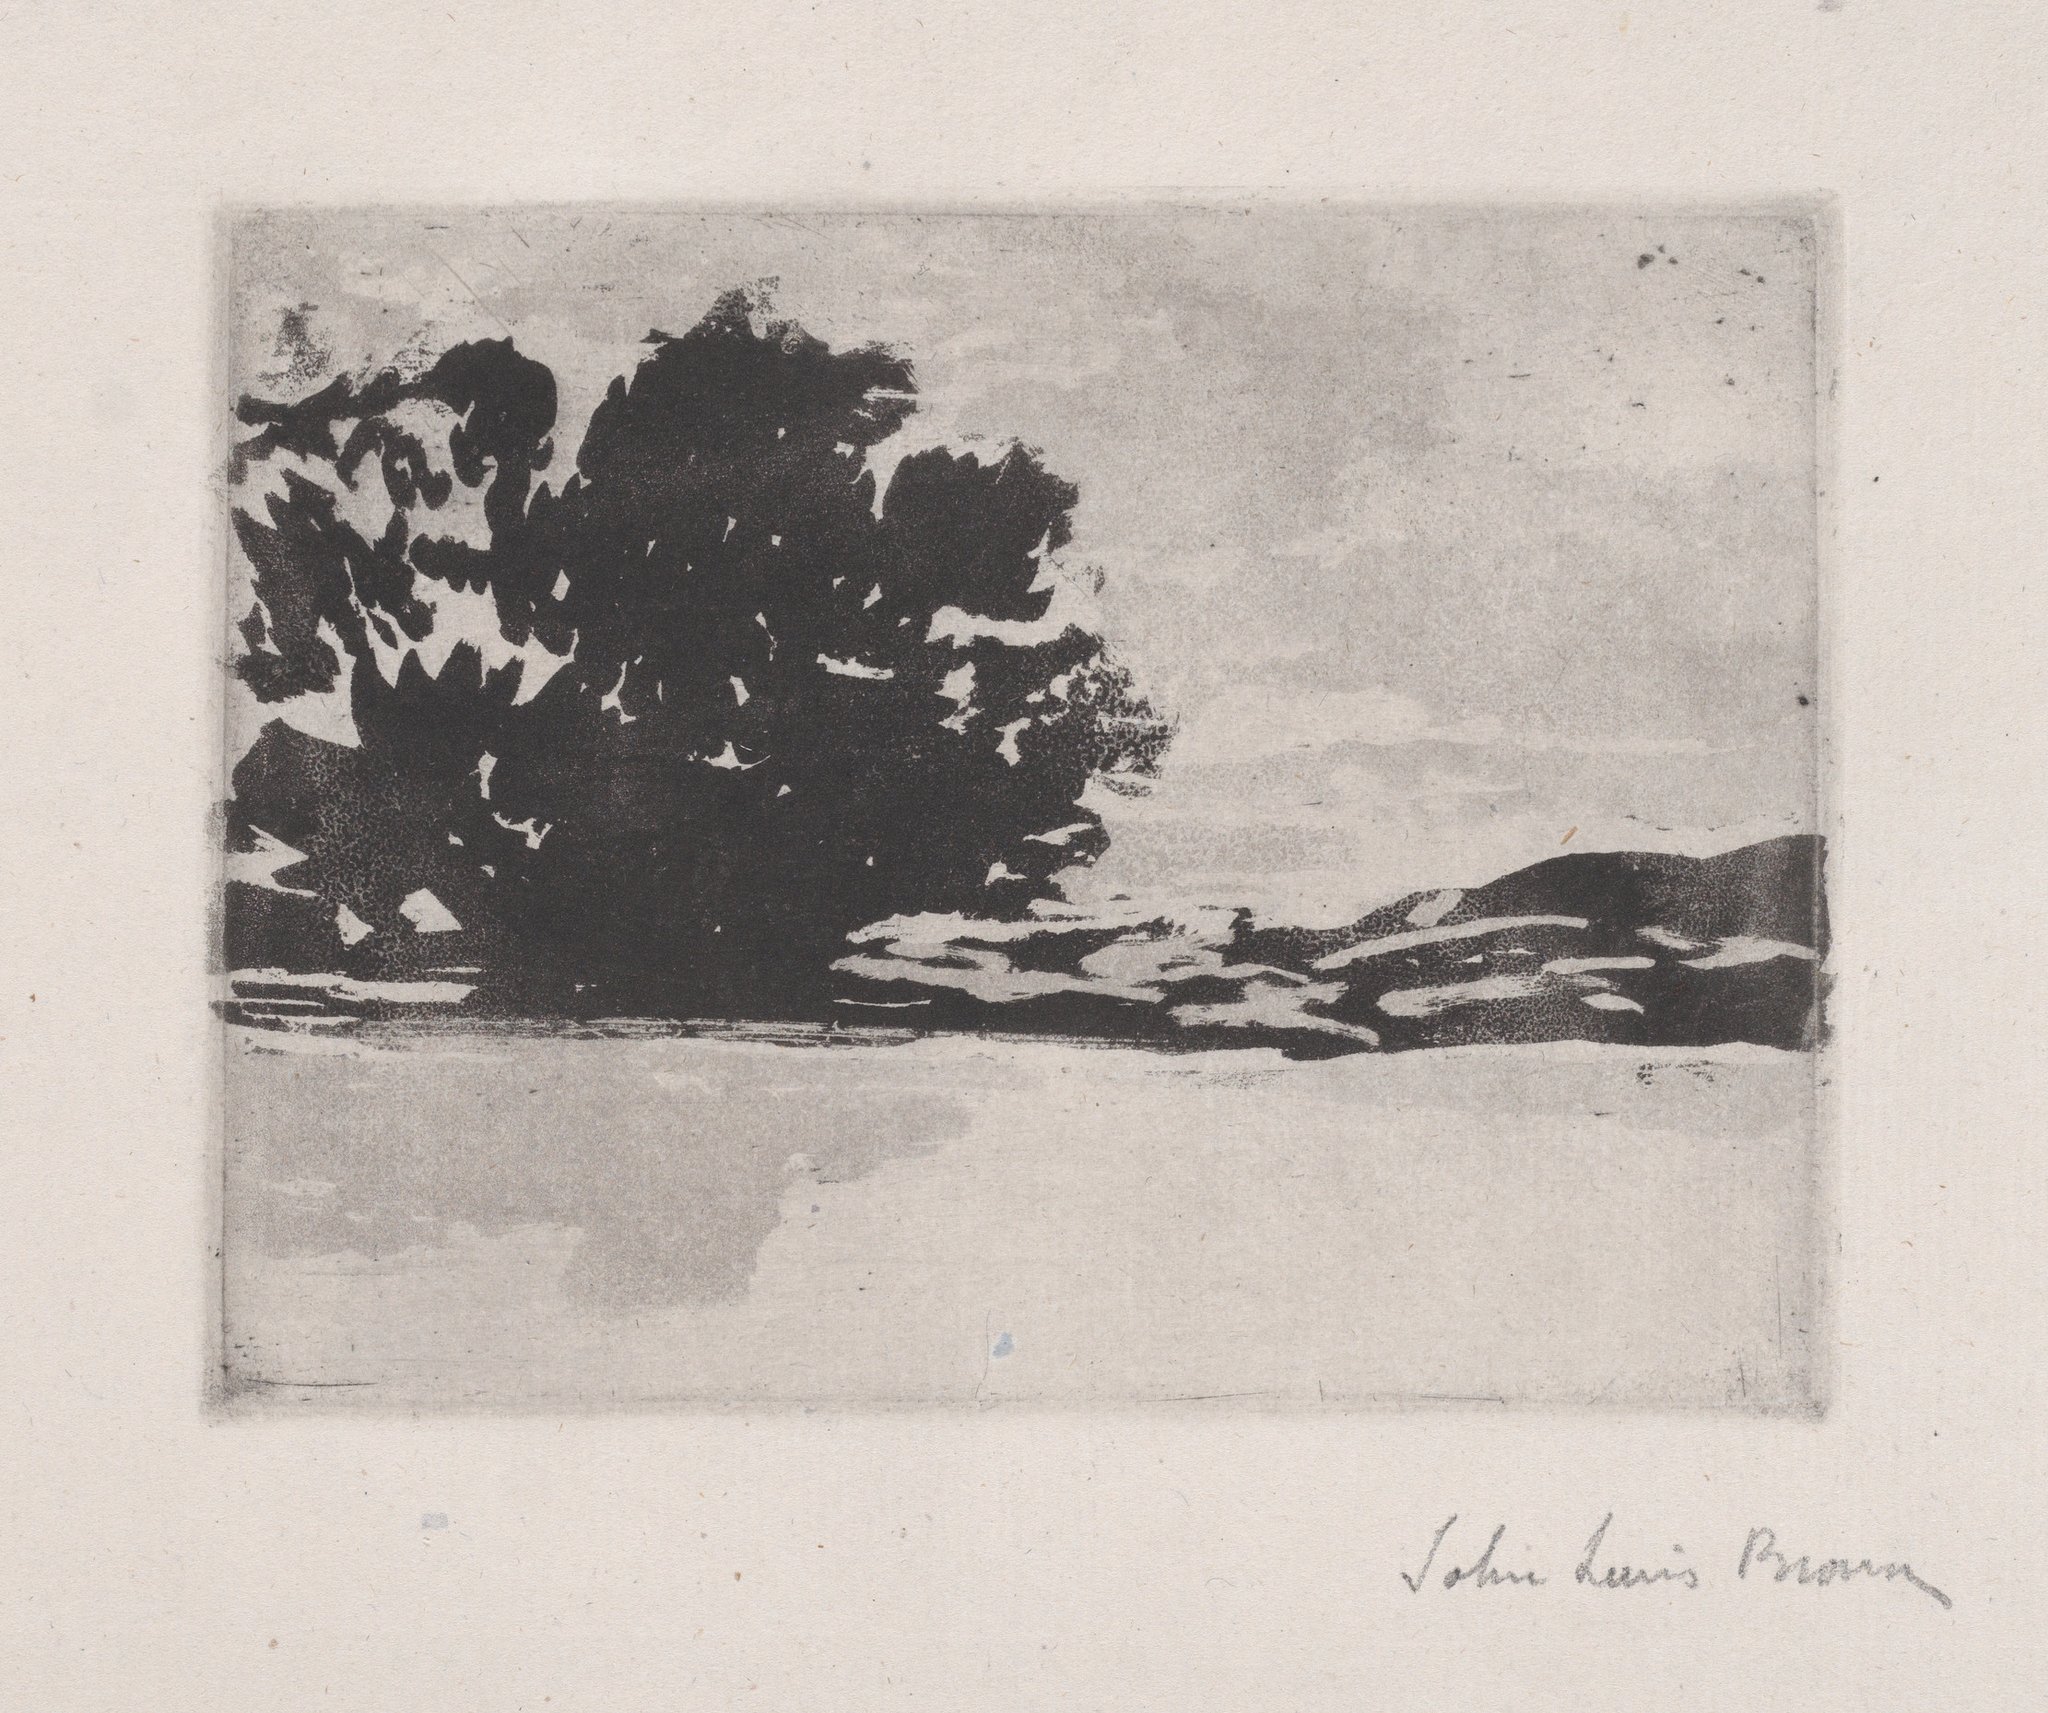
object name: print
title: Paysage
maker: john-lewis brown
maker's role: artist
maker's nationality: french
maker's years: 1829-1890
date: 1801-1900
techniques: aquatint